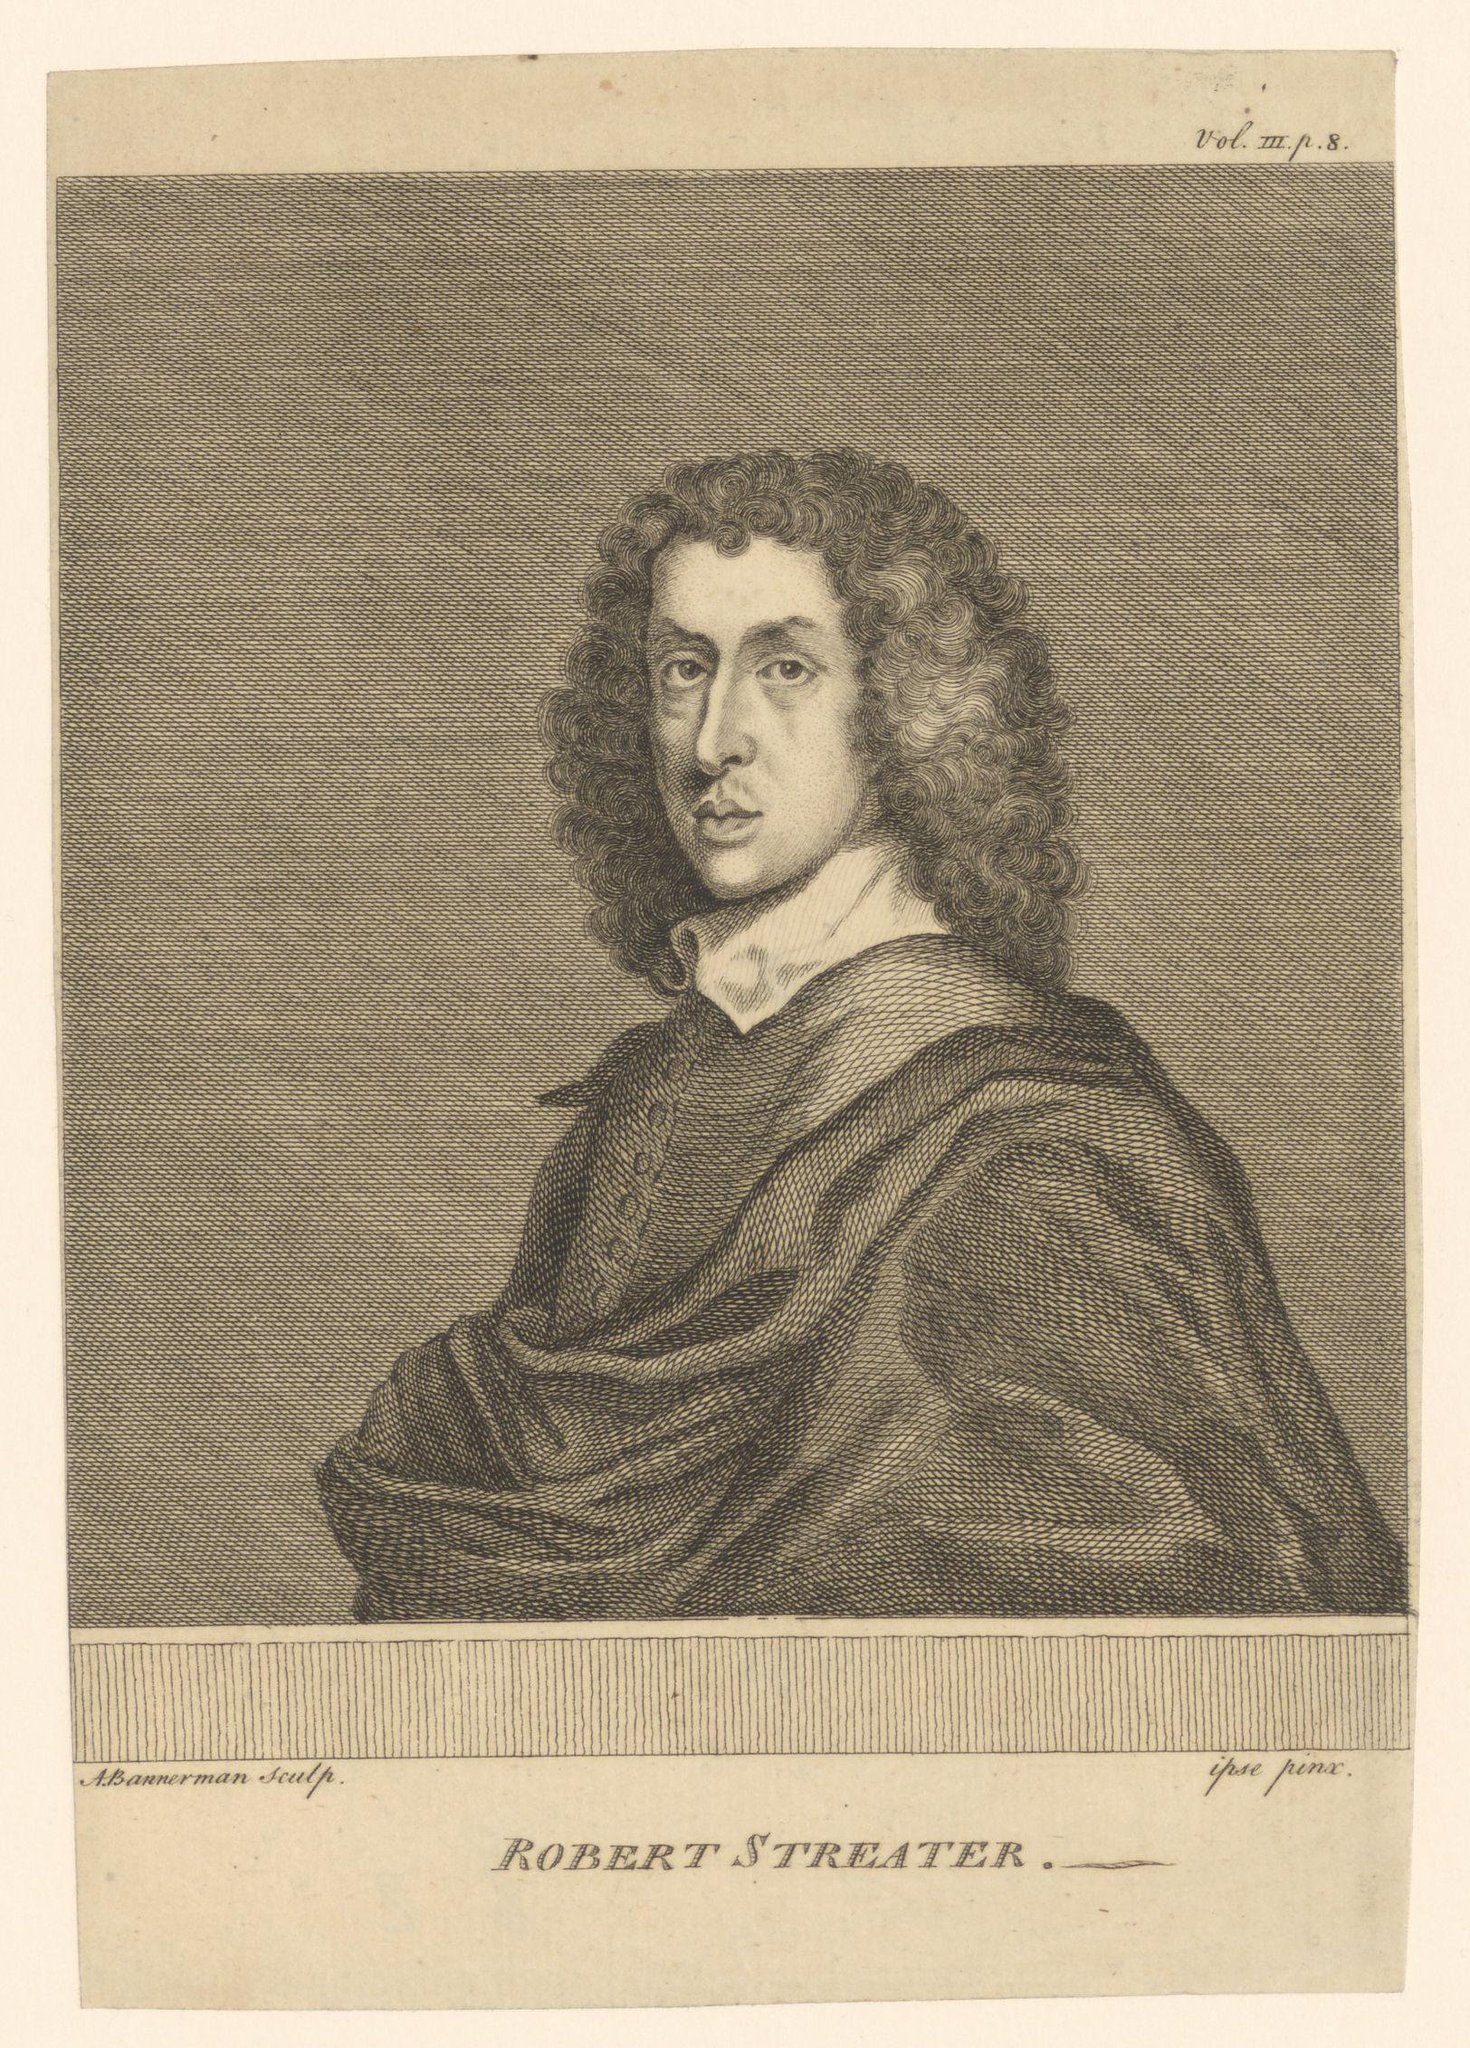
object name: print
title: Portret van Robert Streater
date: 1763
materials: paper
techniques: engraving, etching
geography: strawberry hill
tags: painter, robert streater, historical persons, portrait, self-portrait of painter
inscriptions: collector's mark: Lugt 2228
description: Prent uit: Vertue, George. Anecdotes of Painting in England (...). Londen: Horace Walpole, 1763, dl. 3, p. 8.